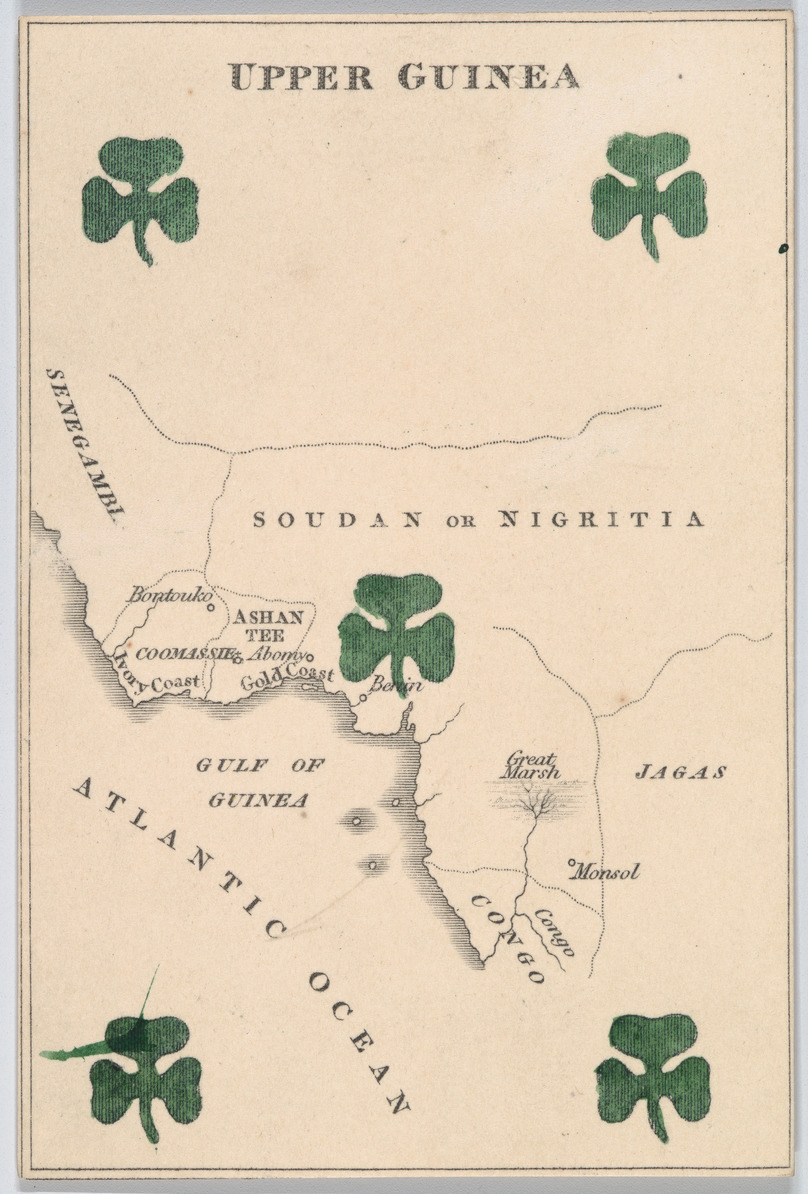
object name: print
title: Upper Guinea, from "Court Game of Geography"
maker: william and henry rock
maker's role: publisher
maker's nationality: british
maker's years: 1821-1884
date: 1838-1855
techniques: engraving, hand coloring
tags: playing cards,maps